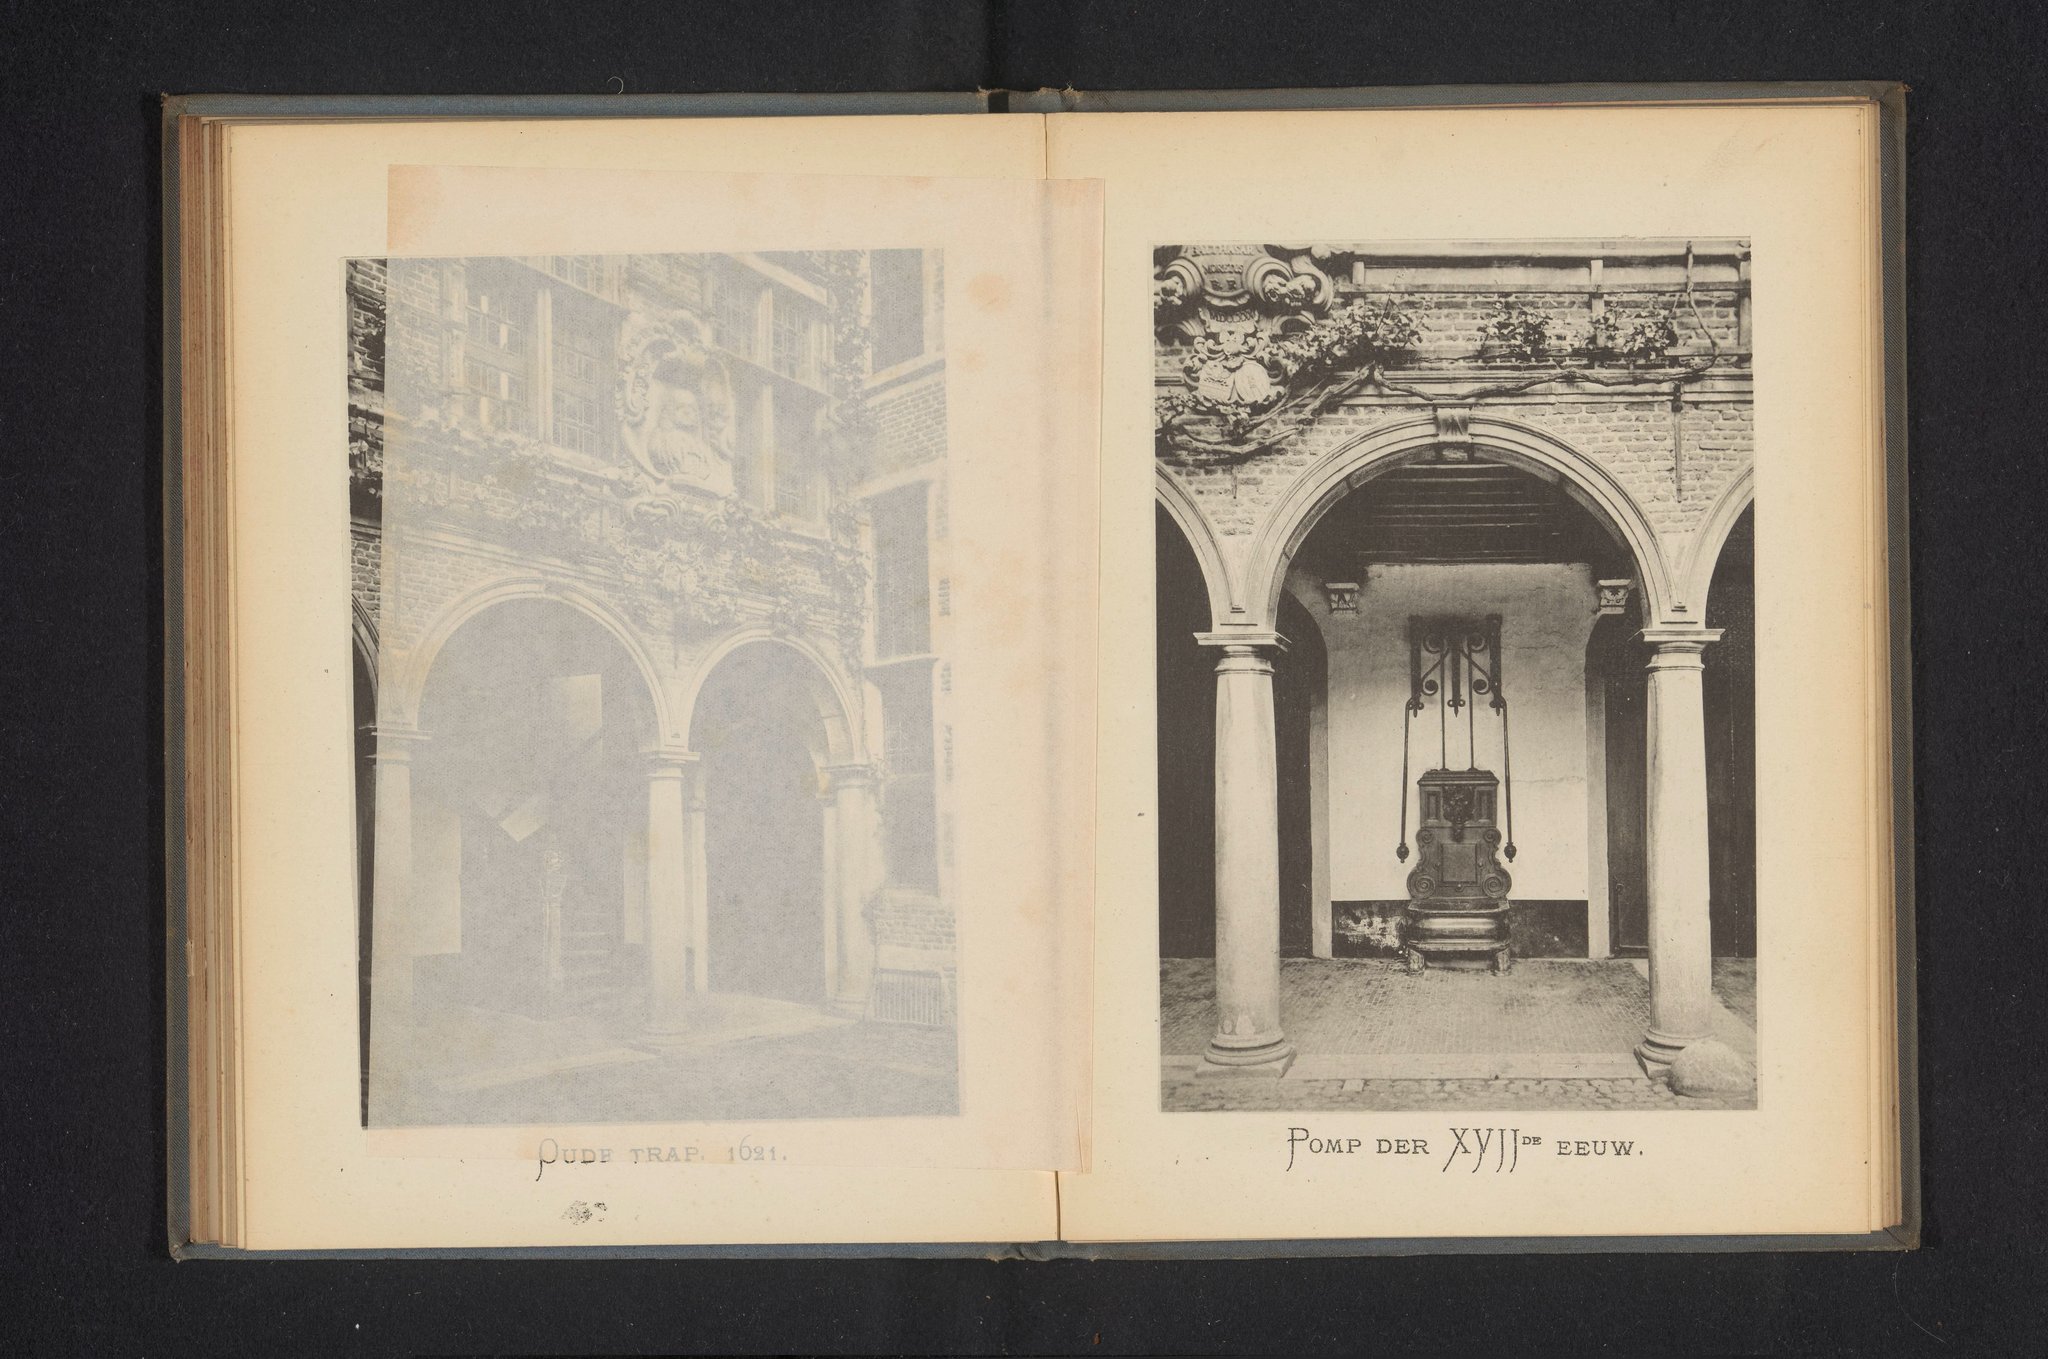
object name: page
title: Pomp der XVIIde eeuw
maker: joseph maes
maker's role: fotograaf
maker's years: 1838-1908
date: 1881-1886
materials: paper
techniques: photograph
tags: courtyard, ornamental fountain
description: Prent op derde ongenummerde pagina na pagina 112.